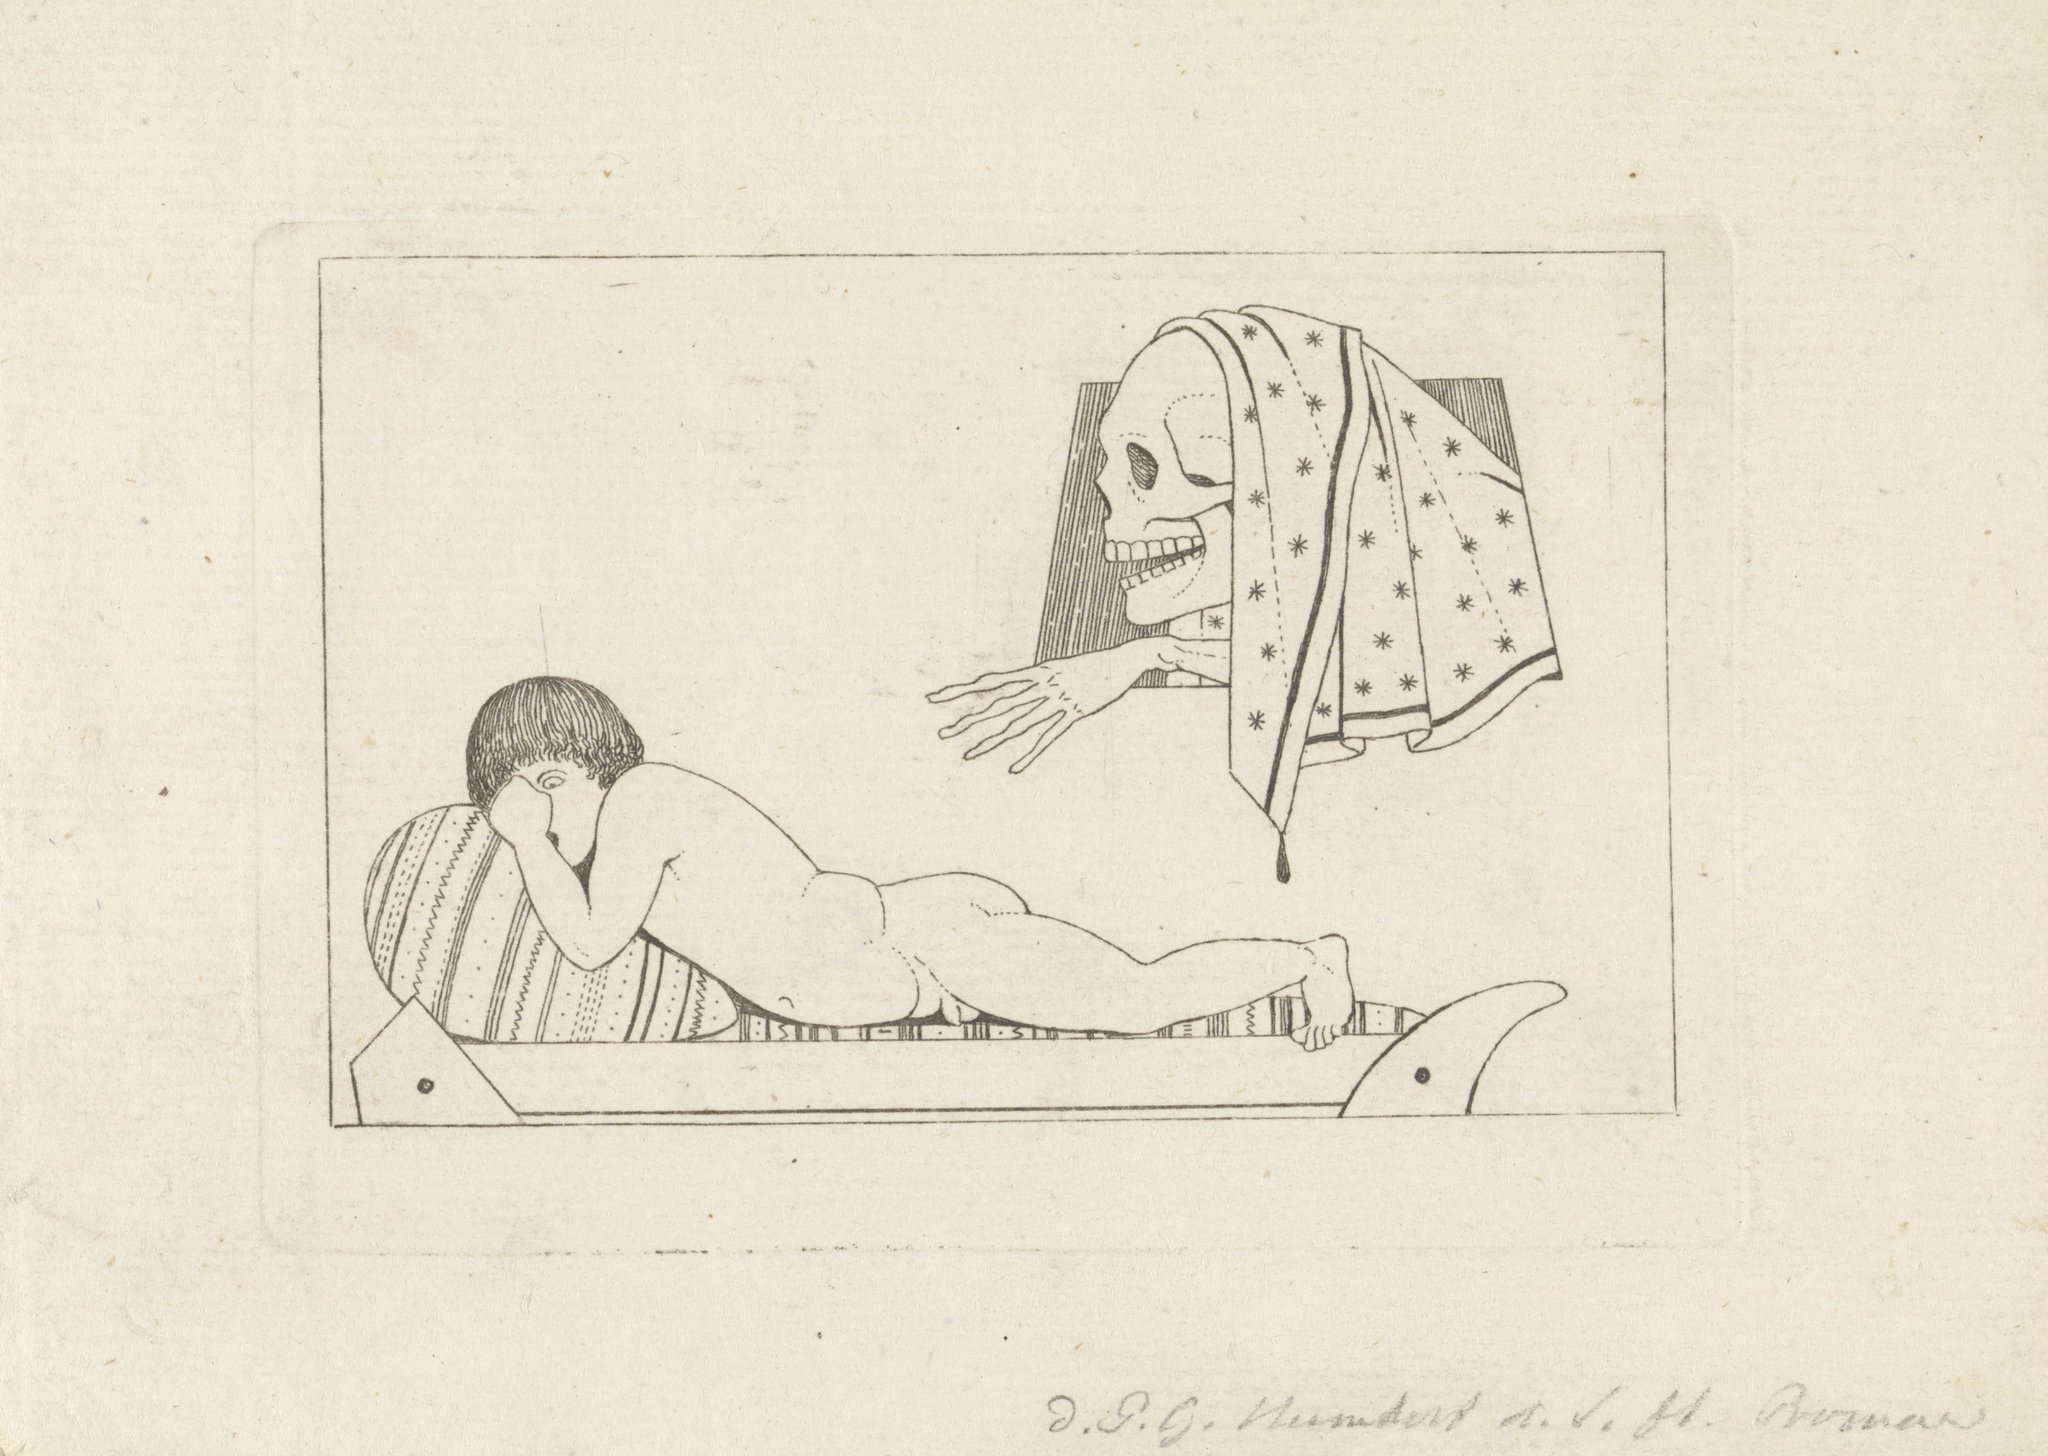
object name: print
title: Allegorische waarschuwing tegen de onanie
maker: david pièrre giottino humbert de superville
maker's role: draughtsman, painter, print maker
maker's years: 1770-1849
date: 1801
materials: paper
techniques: etching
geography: rome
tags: death as skeleton, other scenes ~ the book of jeremiah (with book chapter:verse), masturbation, onanism (+ variant)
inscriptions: collector's mark: Lugt 2228, collector's mark: Lugt 2760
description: Een naakte jongen ligt op zijn buik op een rustbed. Rechtsboven reikt de Dood met zijn hand door een raam naar de jongen. De Dood draagt een sjaal over zijn schedel. Op basis van het bijbelvers in Jer. 9:20 gaat het hier om een allegorische waarschuwing tegen onanie of zelfbevrediging.